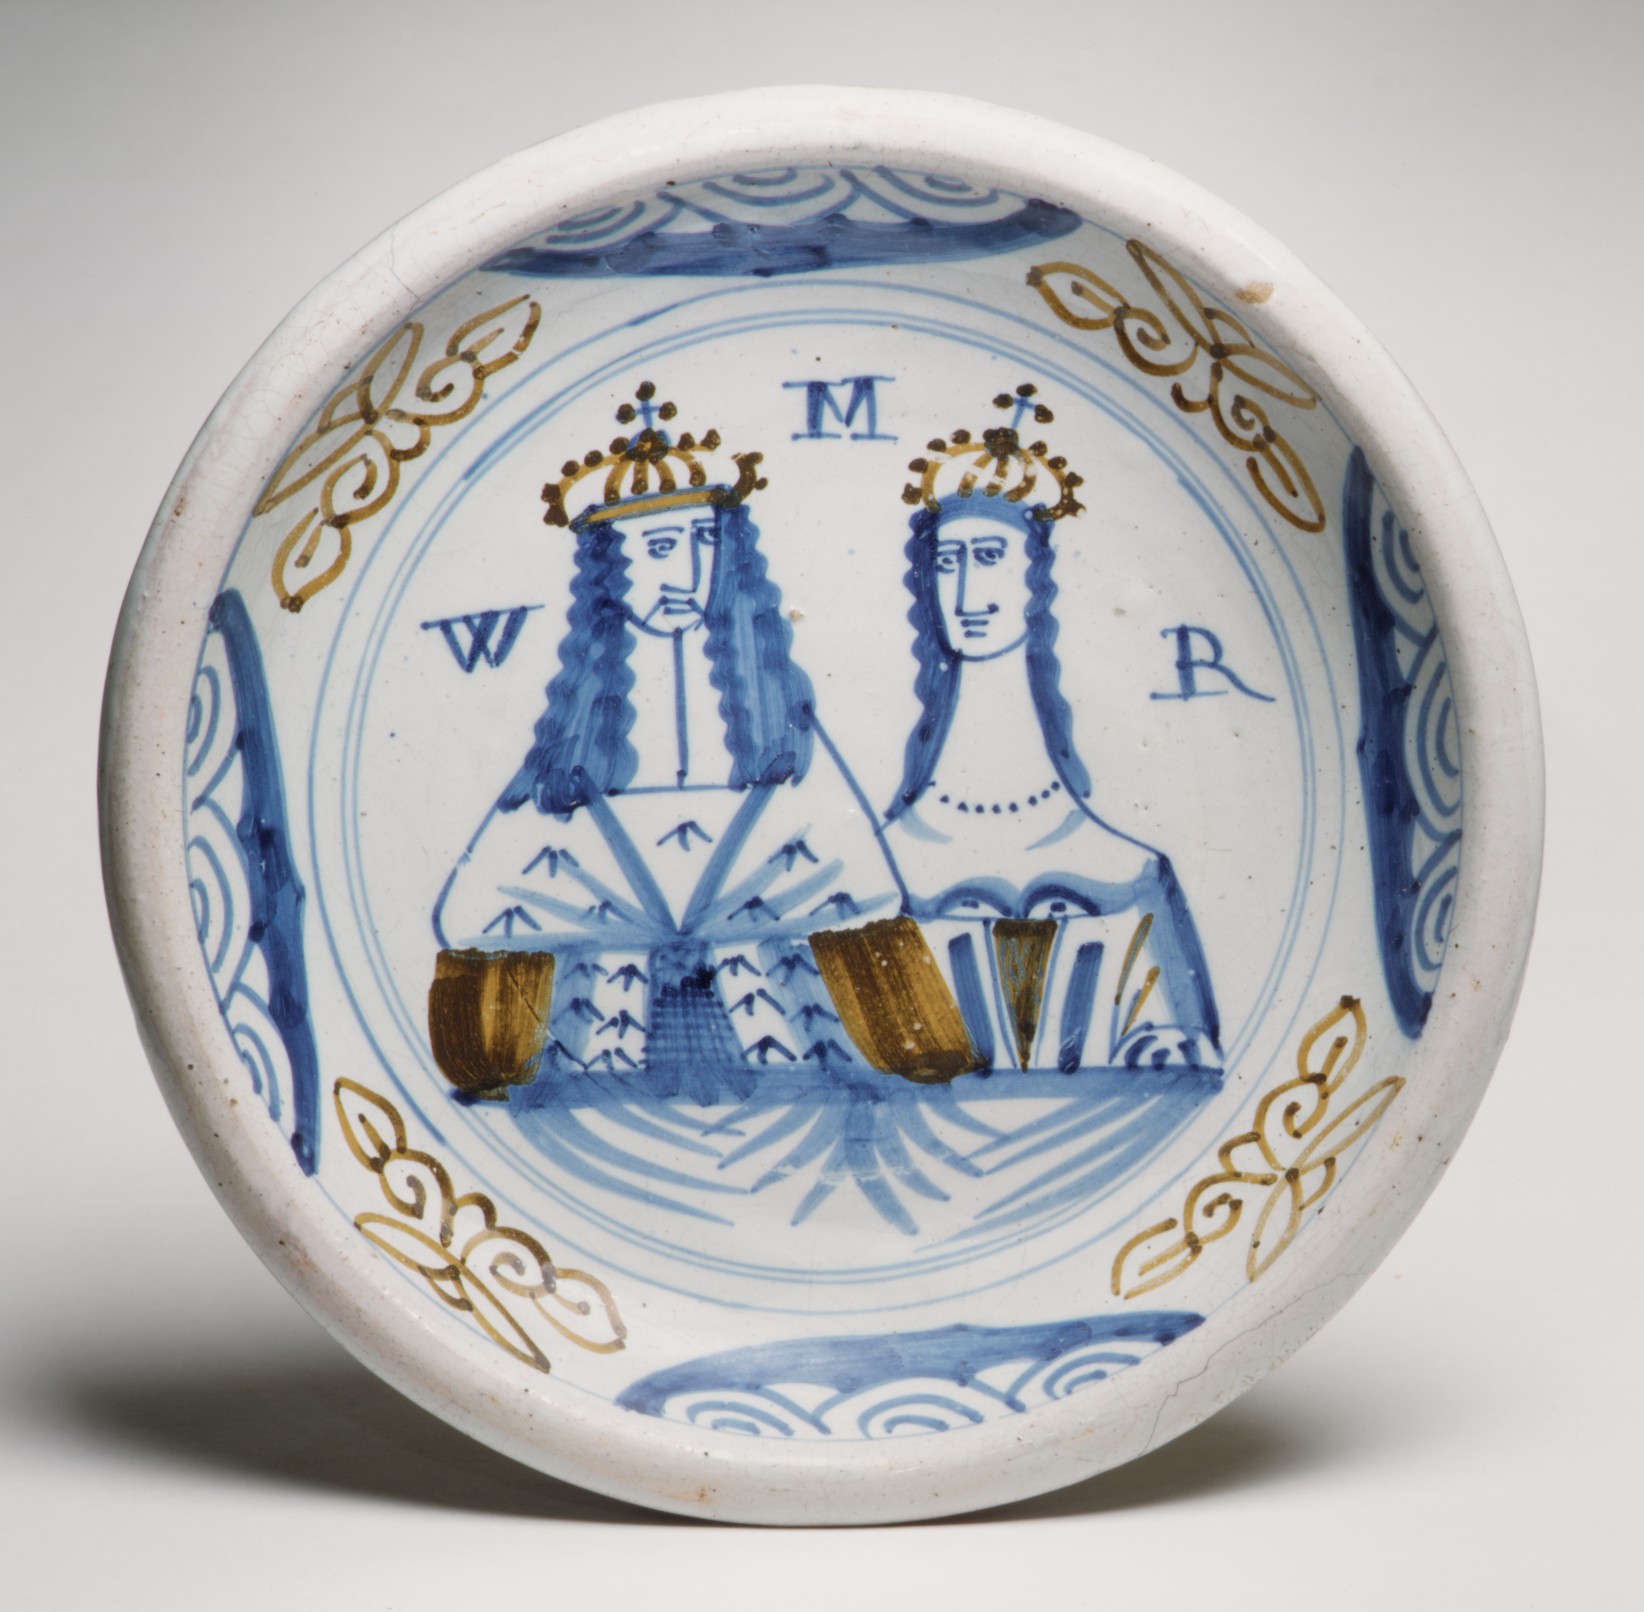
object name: dish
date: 1690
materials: earthenware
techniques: glazing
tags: kings,queens